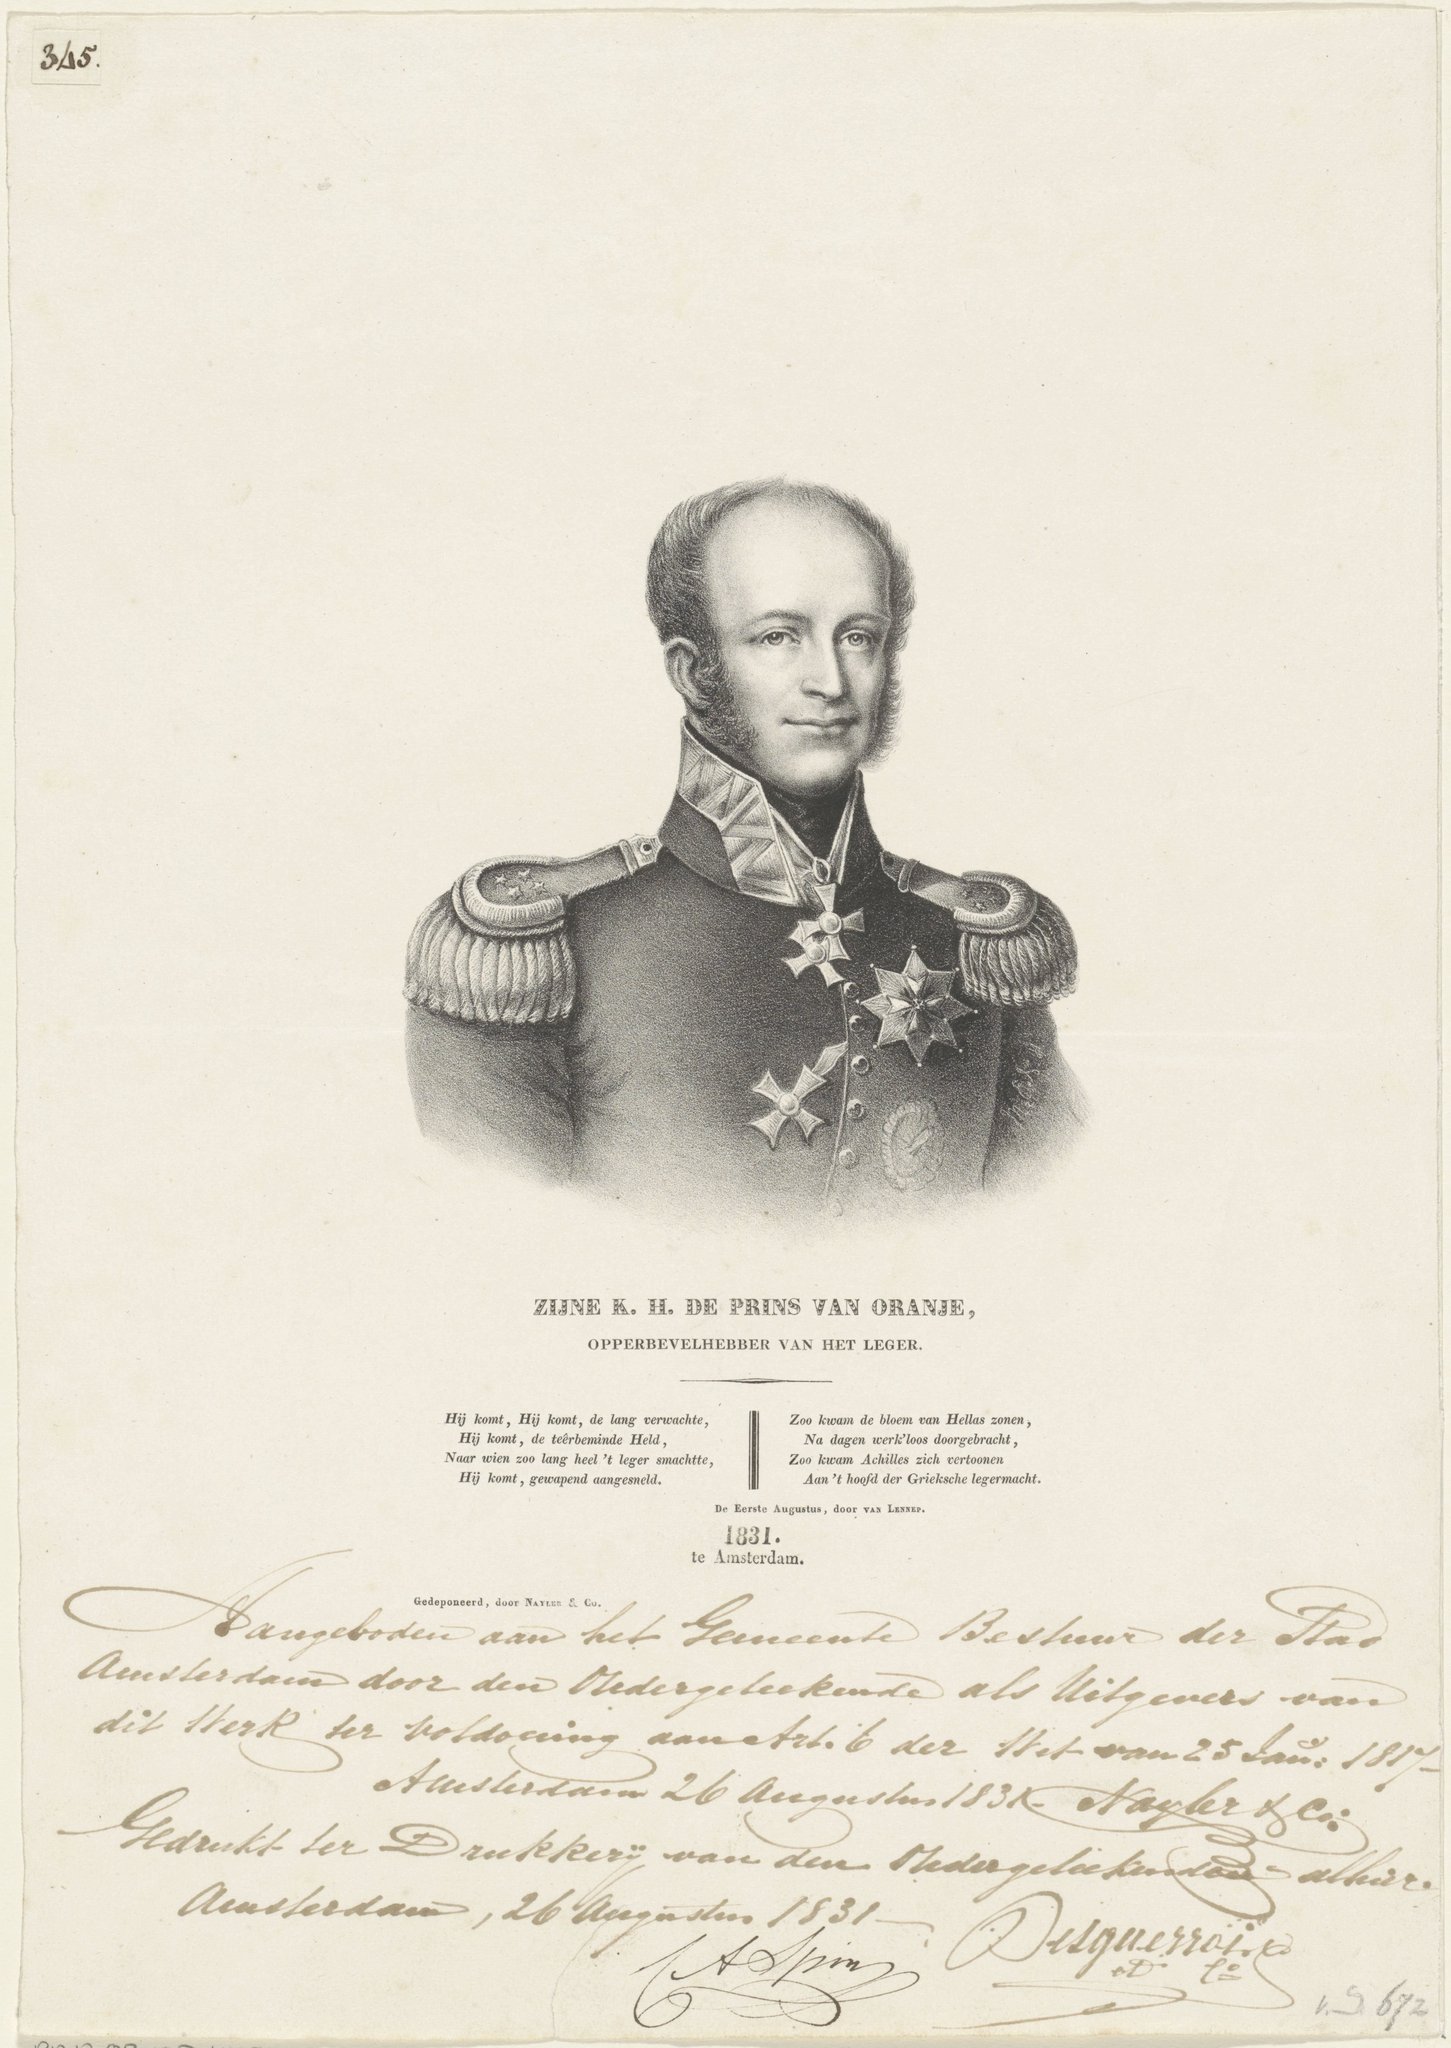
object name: print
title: Portret van Willem II, koning der Nederlanden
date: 1831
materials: paper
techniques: letterpress printing, lithograph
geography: amsterdam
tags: william ii of the netherlands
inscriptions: : ‘Aangeboden aan het Gemeente Bestuur der Stad Amsterdam door den Ondergeteekende als Uitgever van dit Werk ter voldoening aan Art. 6 der Wet van 25 Jan.y 1817. Amsterdam 26 Augustus 1831. Nayler & Co: / Gedrukt ter Drukkerij van den Ondergeteekenden alhier. Amstwerdam, 26 Augustus 1831. Desguerrois et Co. / C.A, Spin //’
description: De hier vermelde titel verwijst naar de hoogst verkregen titel van de geportretteerde, niet per se naar de titel die de geportretteerde op deze voorstelling draagt.